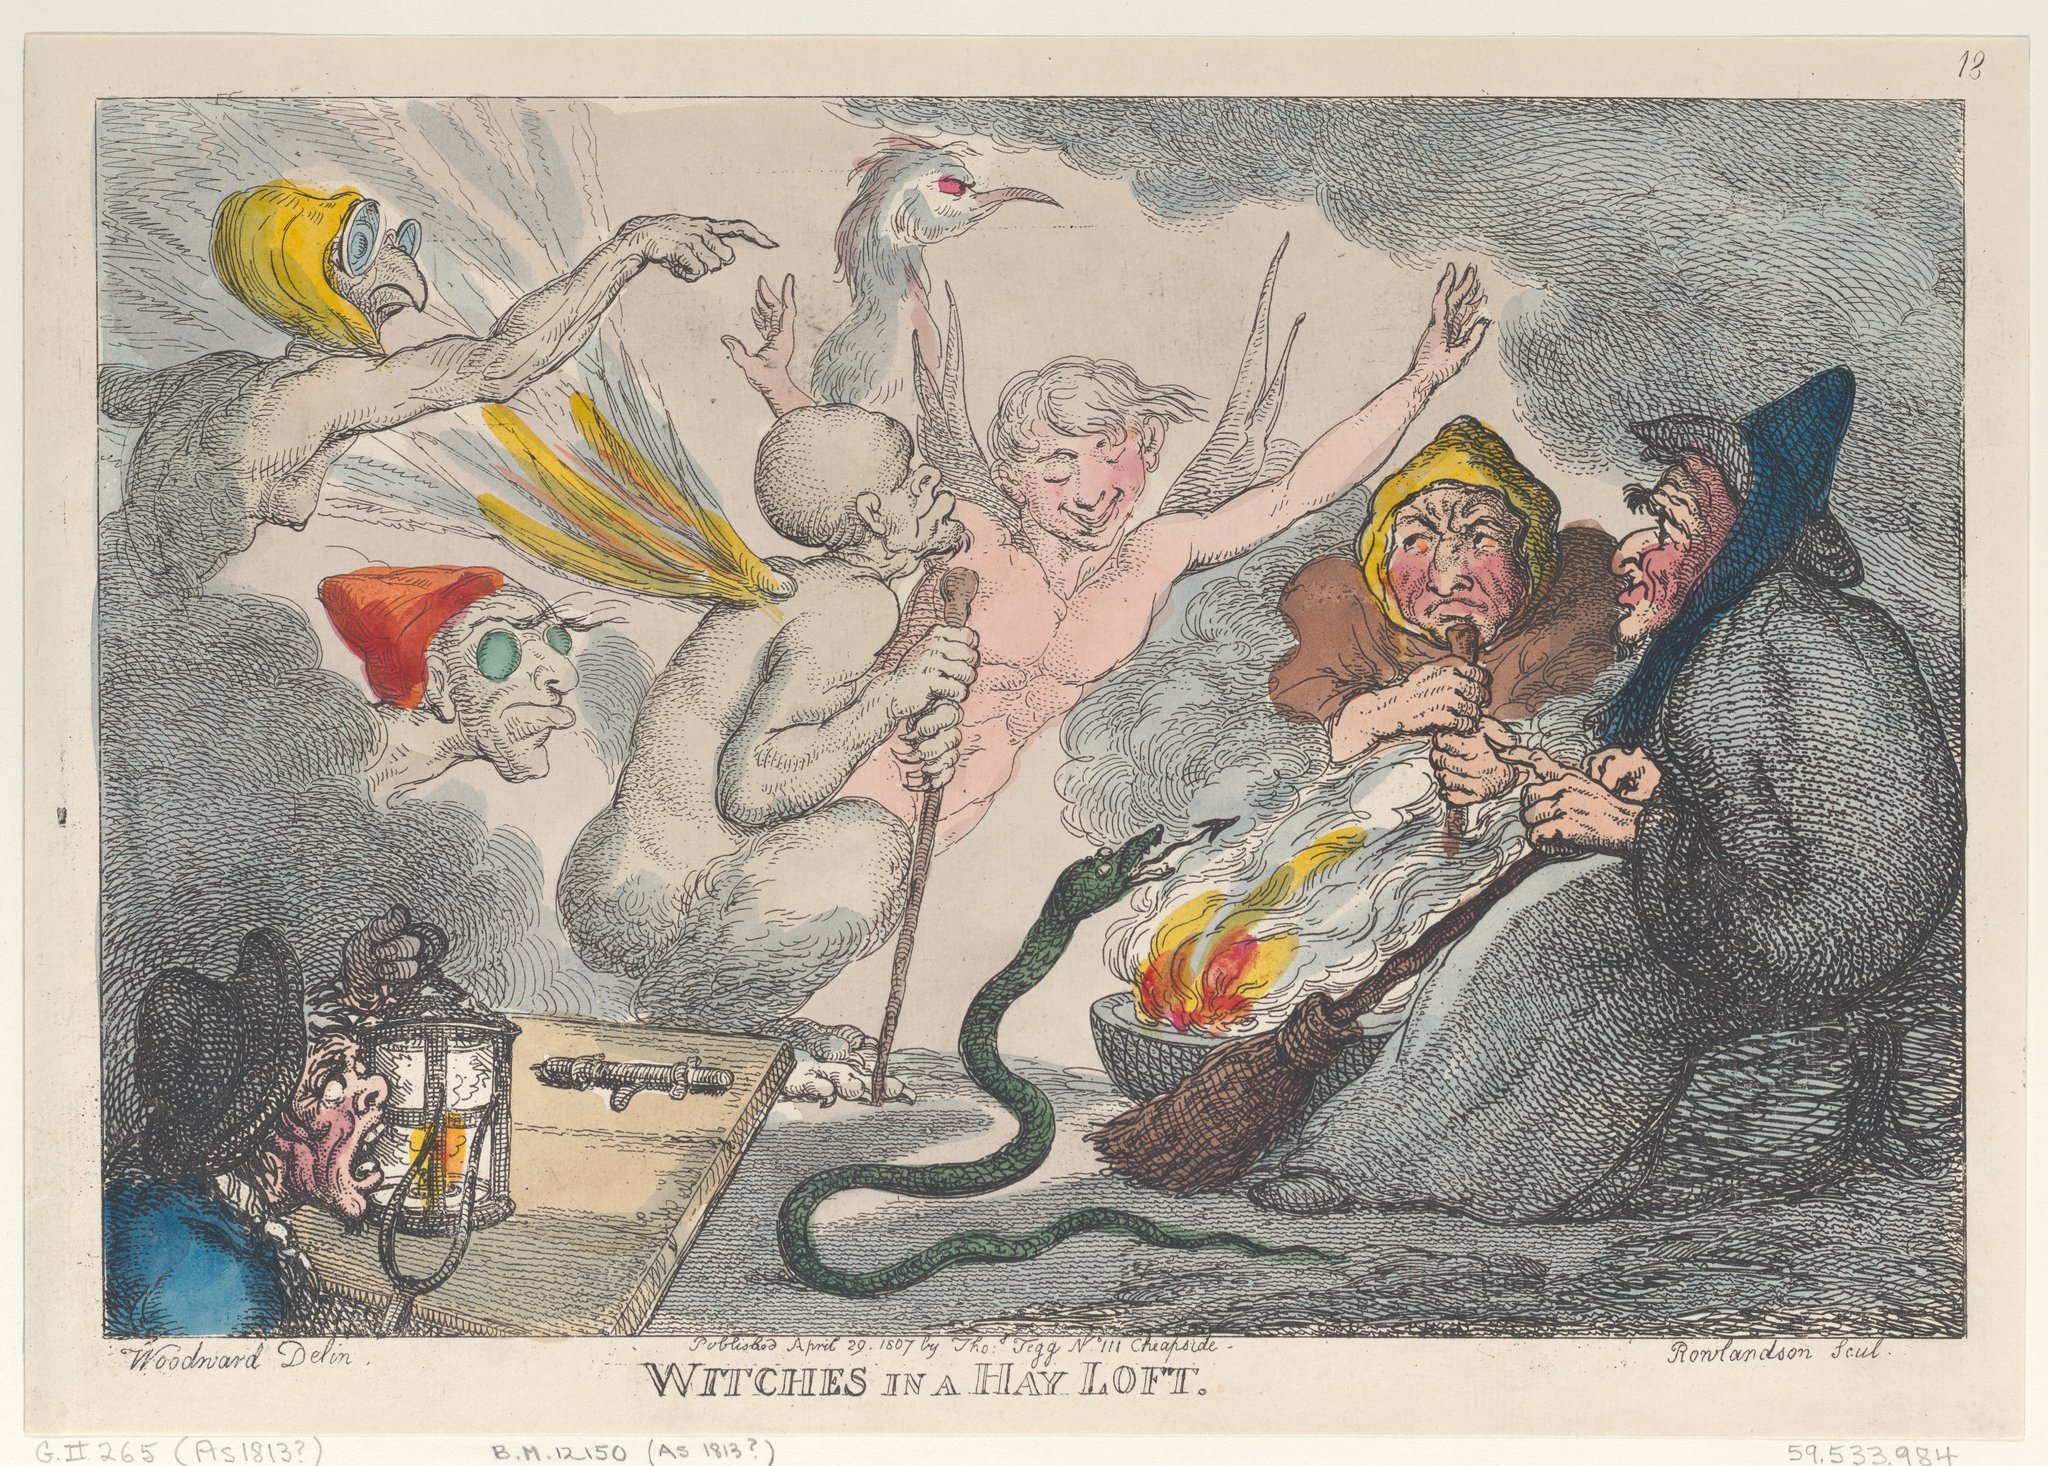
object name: print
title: Witches in a Hay Loft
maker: thomas rowlandson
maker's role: artist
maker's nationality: british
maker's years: 1757-1827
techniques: etching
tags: satire,men,women,monsters,snakes,witches